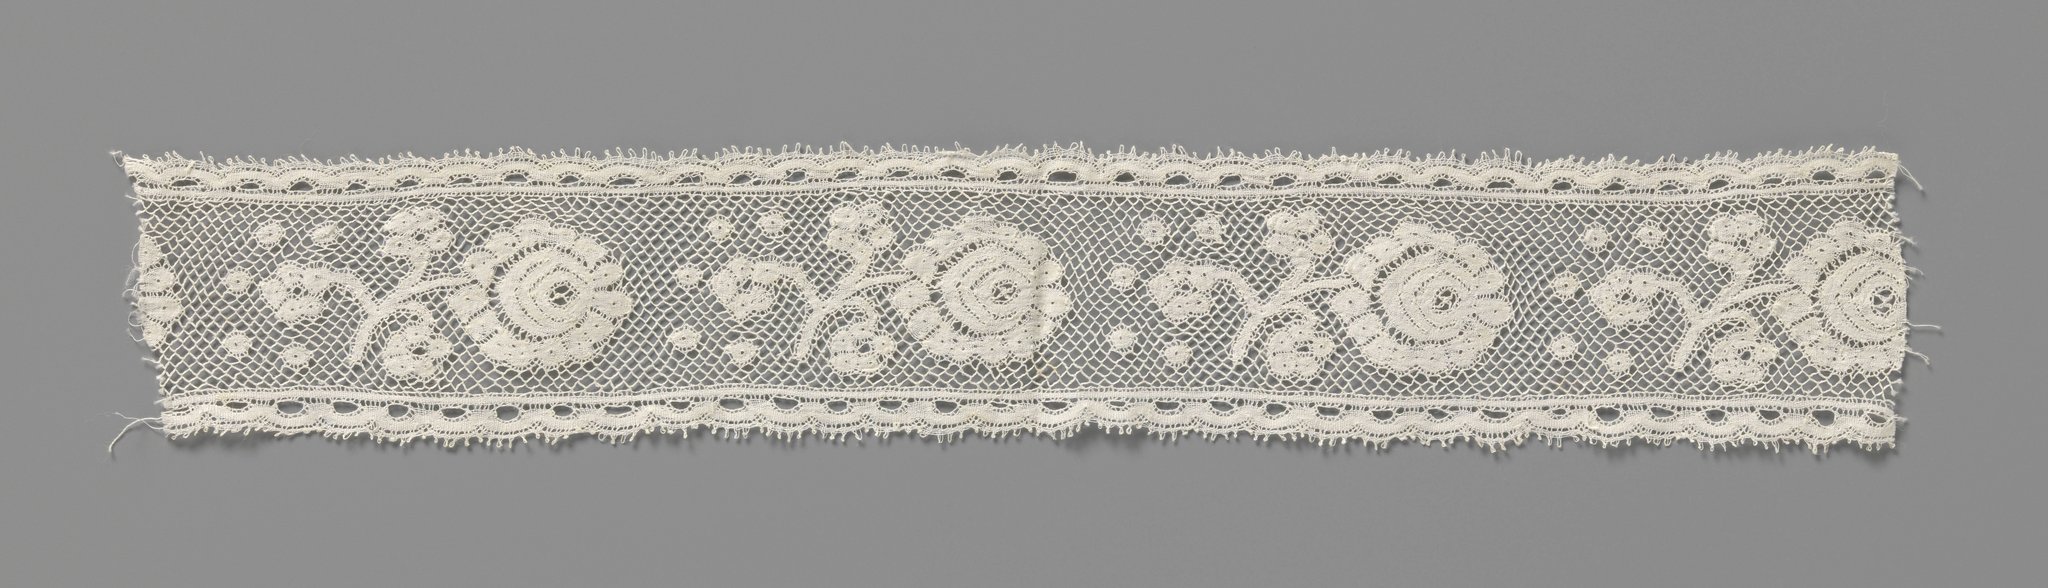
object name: strip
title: Tussenzetsel van kloskant met roosjes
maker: Anonymous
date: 1890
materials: linen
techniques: lace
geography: ieper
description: Tussen twee boogjesrandjes, met openingen voor een lintje, loopt een baan met vierkante mazen, waarop een rij roosjes aan kromme takjes staan. Valenciennes-kant.